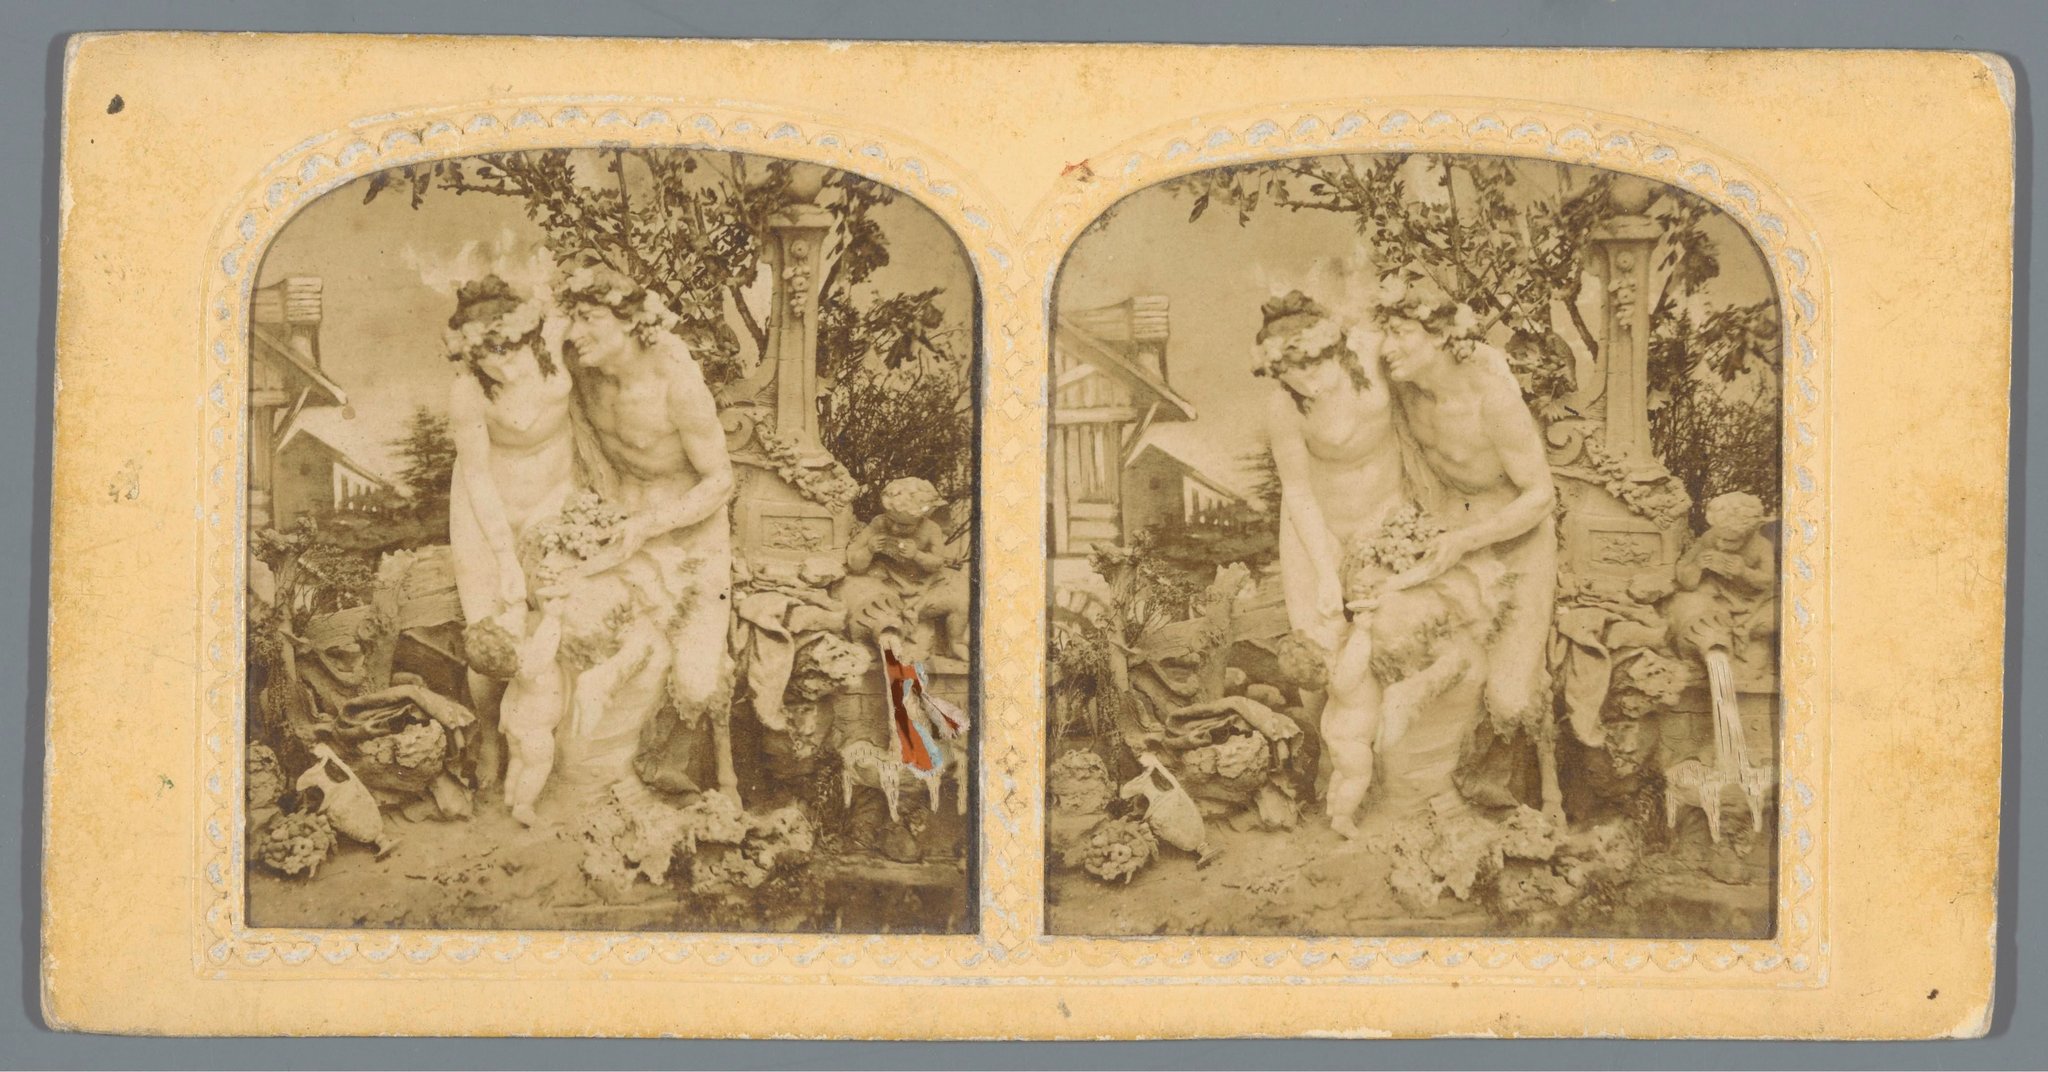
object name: tissue stereograph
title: Mythologische figuren, vermoedelijk uit was, voor een decor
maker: Anonymous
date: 1850-1880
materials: cardboard, photographic support, paper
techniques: albumen print, hand coloring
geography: europe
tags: satyr(s) (in general), cupids: 'amores', 'amoretti', 'putti', europe